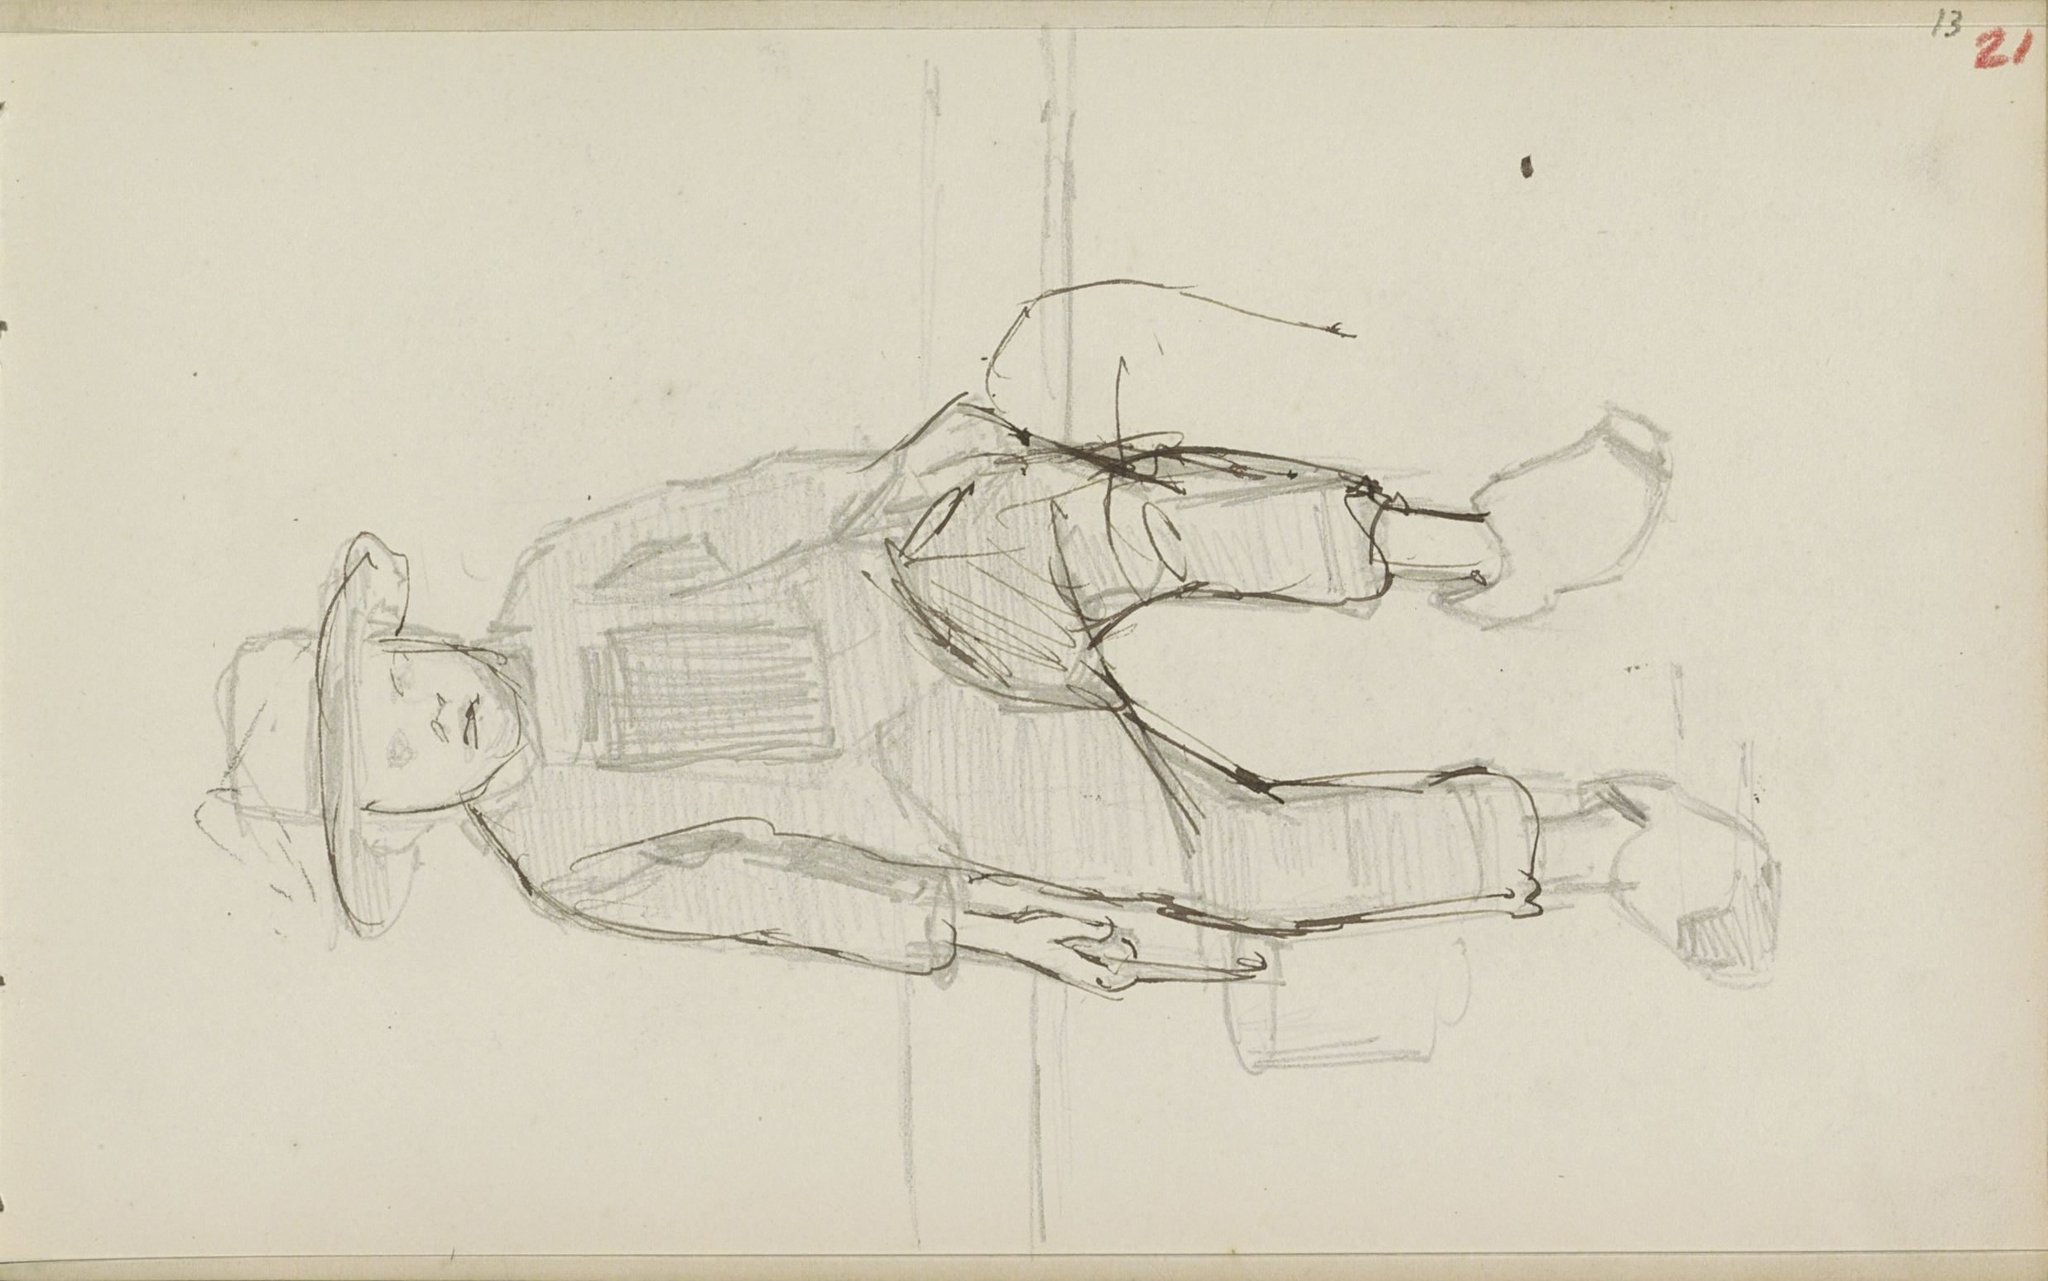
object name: sketchbook leaf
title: Zittende jongen met een emmer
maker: jozef israëls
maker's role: draughtsman, painter, print maker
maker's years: 1824-1911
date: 1834-1911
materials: ink, paper, pencil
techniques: pen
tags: wooden shoes, clogs, sitting figure (+ young male (human being)), container of metal: bucket, can, canister, drum, tin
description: De jongen draagt een hoed en klompen. Blad 13 recto uit een schetsboek met 37 bladen.